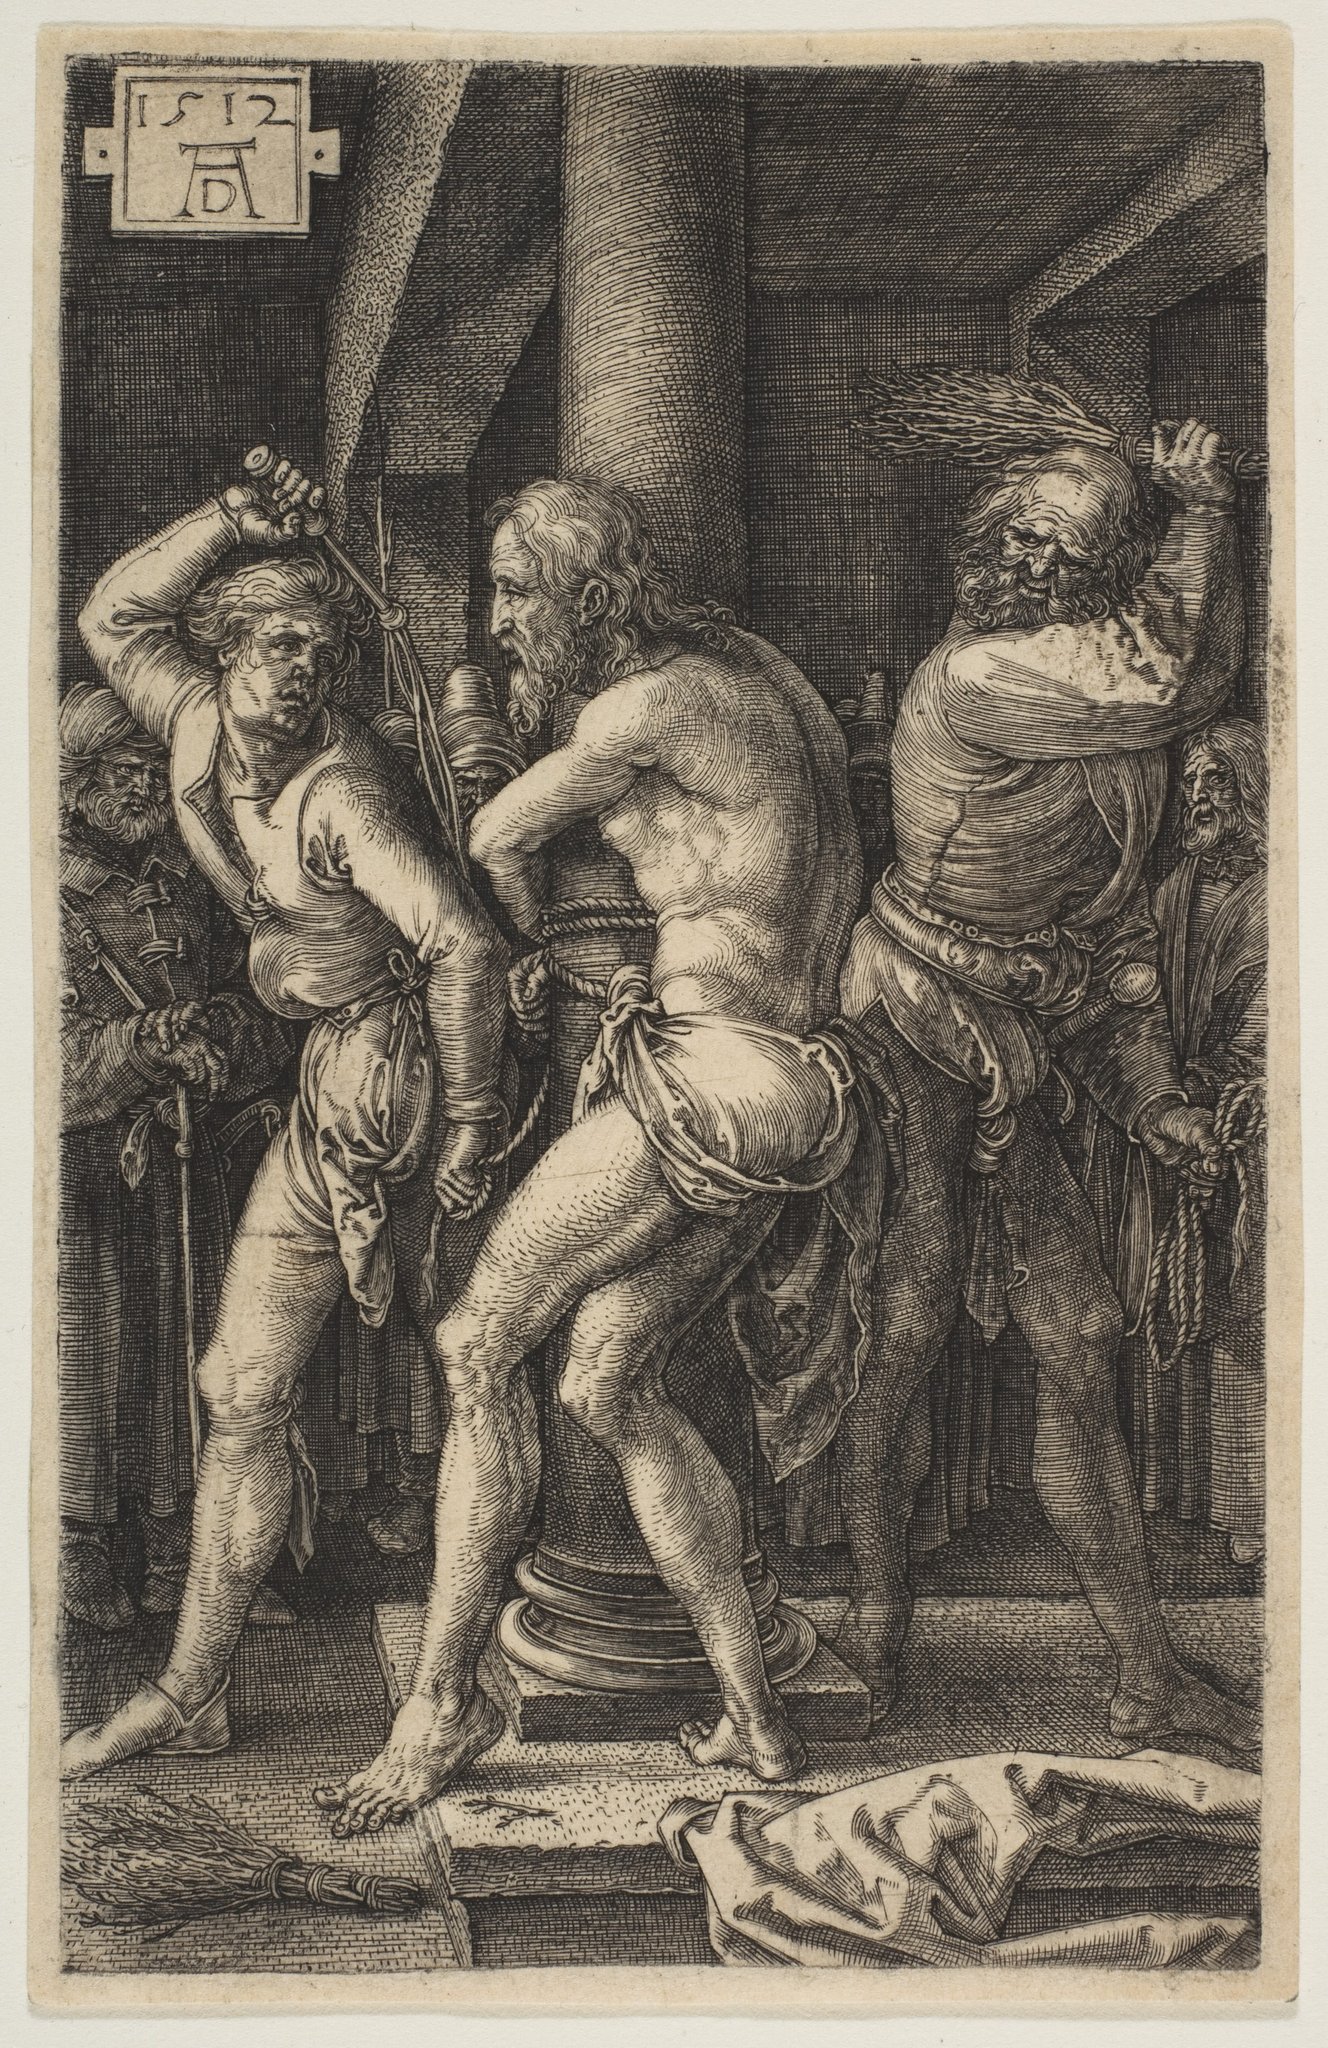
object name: print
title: The Flagellation, from "The Passion"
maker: albrecht dürer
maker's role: artist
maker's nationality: german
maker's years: 1471-1528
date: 1512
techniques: engraving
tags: men,christ,punishment